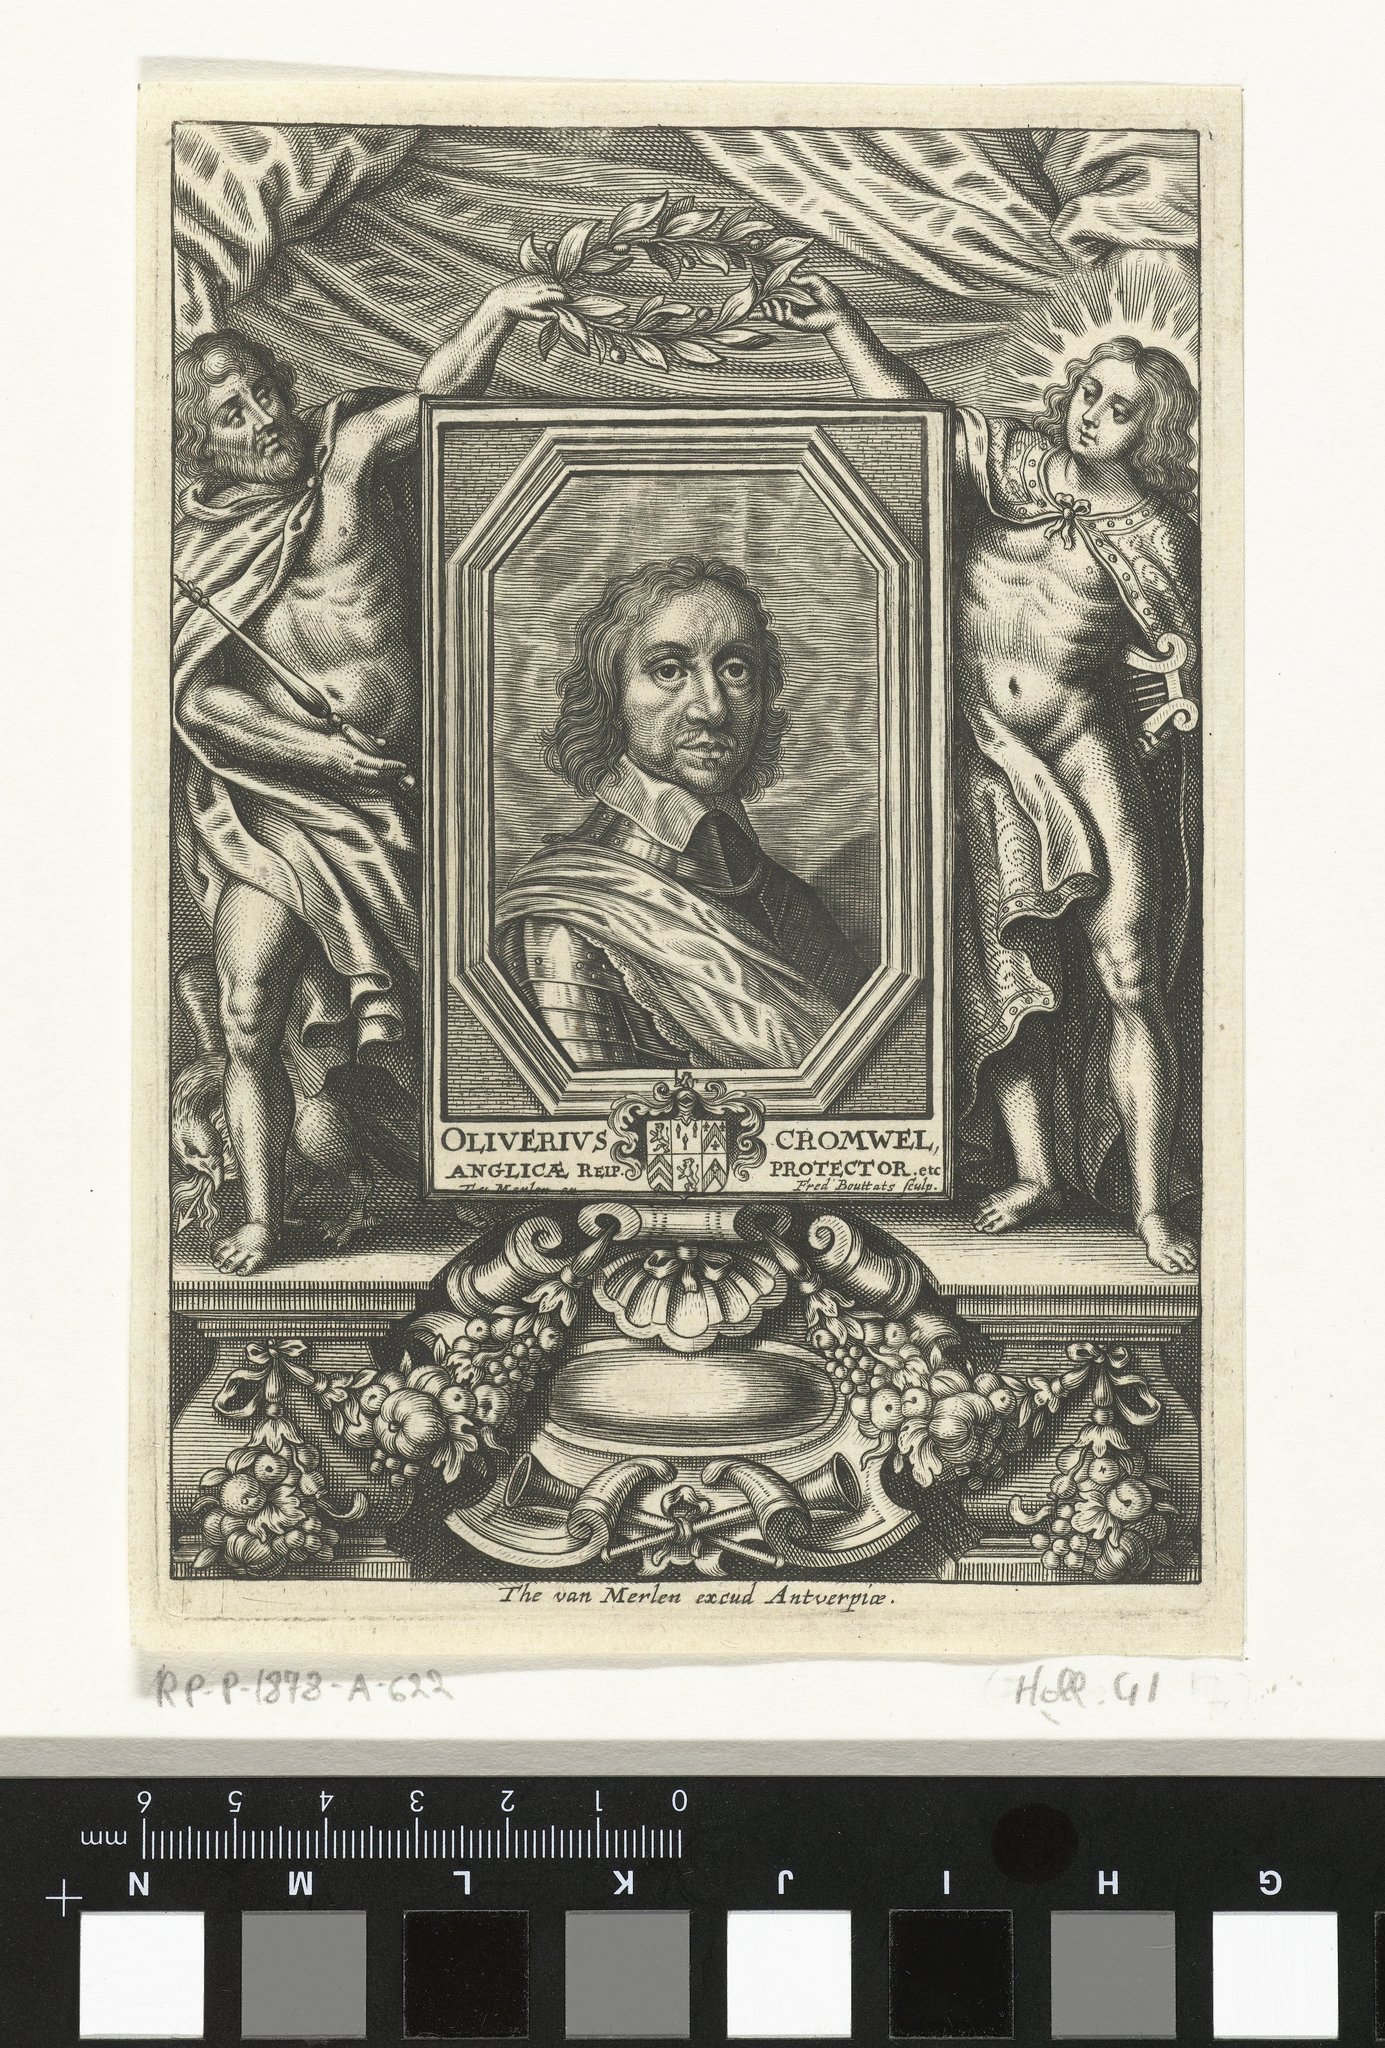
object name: print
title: Portret van Oliver Cromwell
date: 1654-1676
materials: paper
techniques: engraving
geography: antwerp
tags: london, oliver cromwell, (story of) apollo (phoebus), (story of) jupiter (zeus)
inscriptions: collector's mark: Lugt 2228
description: Portret in een ovale lijst van Oliver Cromwell, Lord Protector van Engeland. Buste naar rechts. Cromwell draagt een harnas. Het portret staat in een rechthoekig kader tussen twee klassieke goden, Jupiter en Apollo. Ze houden een lauwerkrans boven het portret.. De prent heeft een Latijns onderschrift met de naam van de geportretteerde.